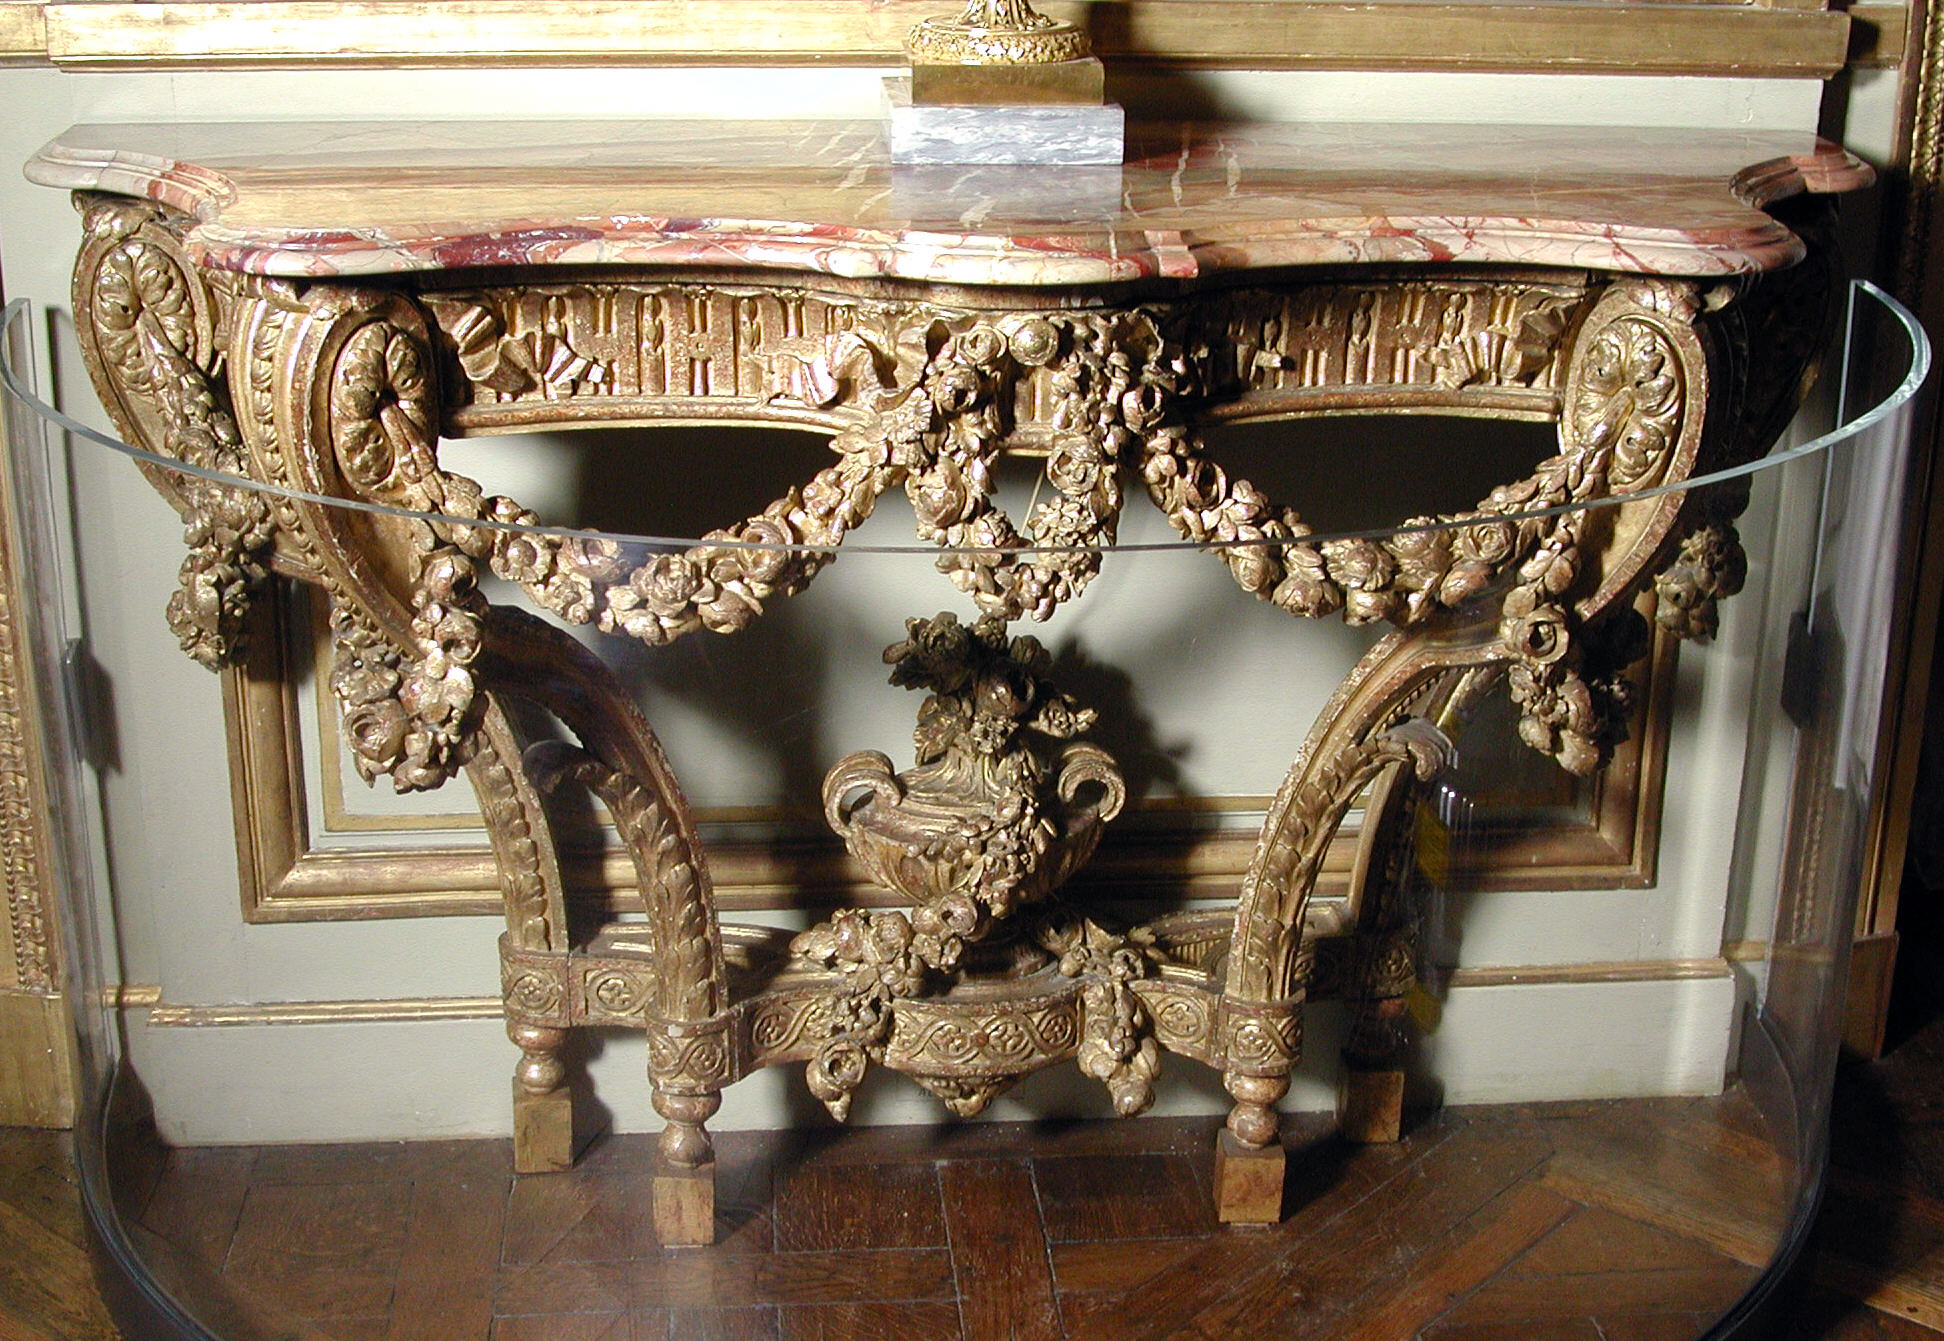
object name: console table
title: Console table (one of a pair)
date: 1765-1770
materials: marble, wood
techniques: carving, gilding